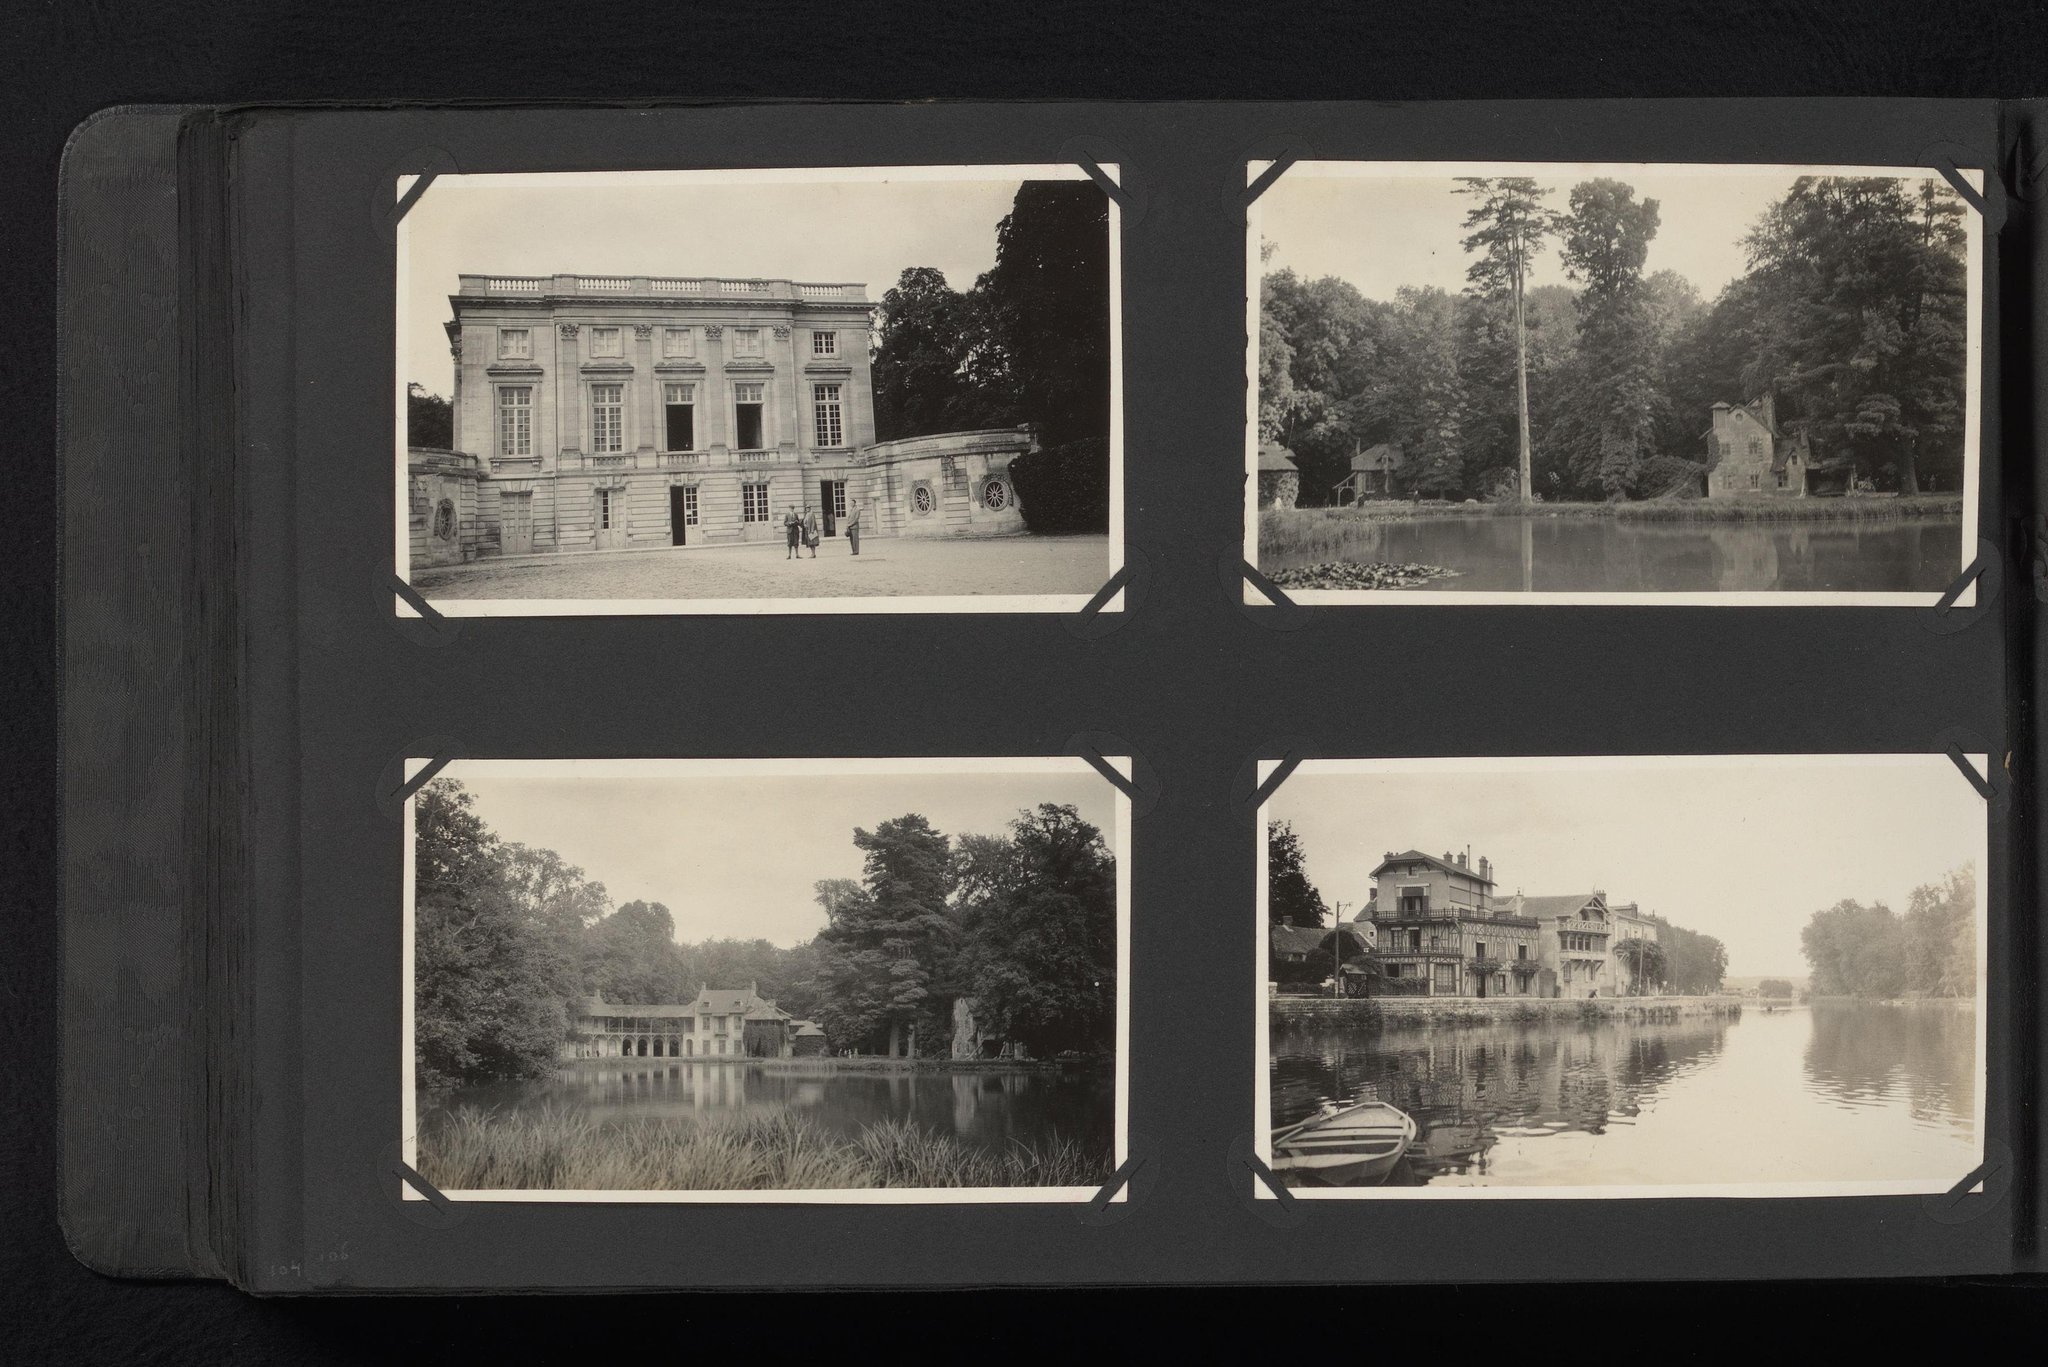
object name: album leaf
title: Vier foto's van de tuinen van het paleis van Versailles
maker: hendrik herman van den berg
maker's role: amateurfotograaf, jurist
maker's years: 1875-1944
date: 1908-1929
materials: paper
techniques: gelatin silver print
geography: versailles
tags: french or architectonic garden; formal garden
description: Deze foto's maken deel uit van een album.